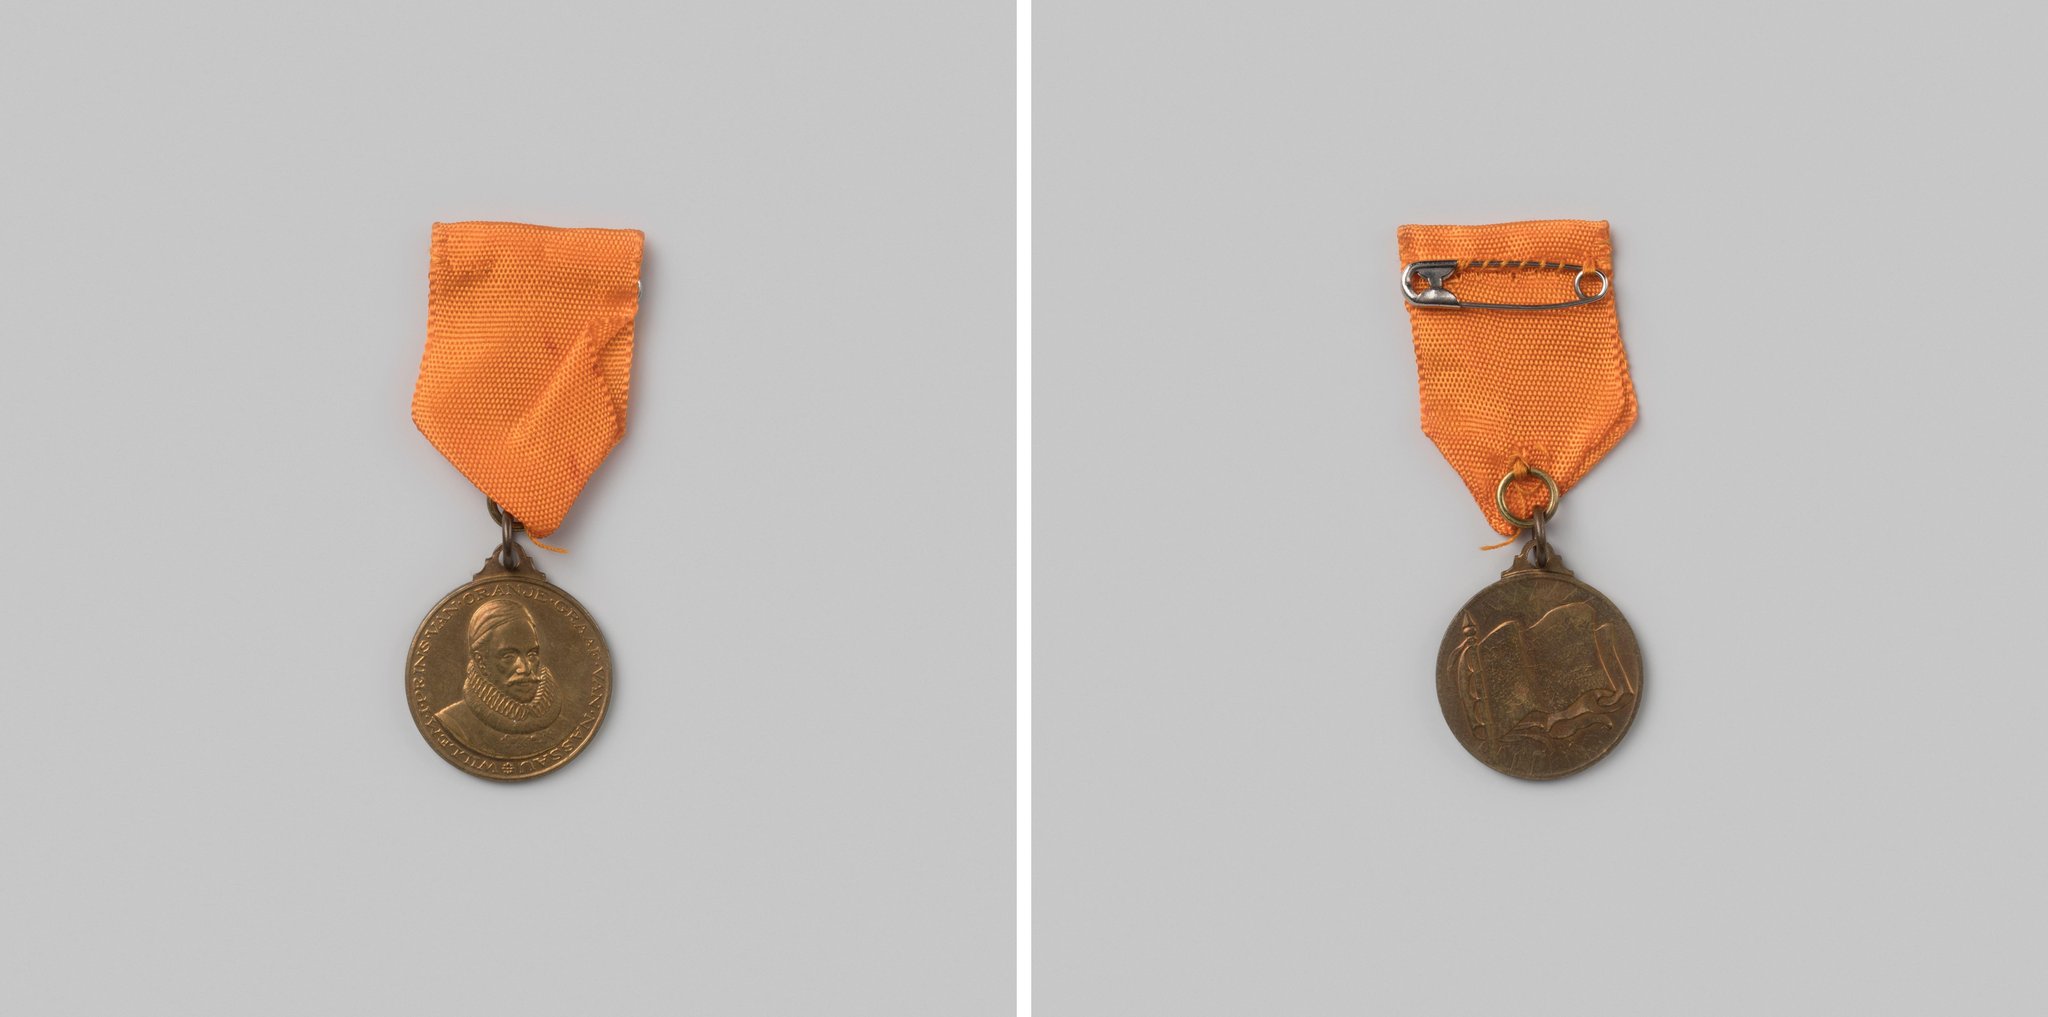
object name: history medal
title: Vierhonderdjarige viering van de geboorte van Willem I, prins van Oranje-Nassau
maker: m.p.j. fleur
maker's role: medailleur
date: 1933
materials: bronze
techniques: striking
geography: voorschoten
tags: william i (prince of orange), netherlands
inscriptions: inscription: ‘WILLEM I PRINS VAN ORANJE GRAAF VAN NASSAU’, inscription: ‘DEN VADERLAND GHETROUWE 1533-1933’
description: Bronzen penning aan draagoog, draagring en oranje lintje. Voorzijde: borststuk man, driekwart frontaal naar rechts met kalotje op het hoofd binnen omschrift. Keerzijde: vlag met opschrift voor bundel van zeven pijlen.